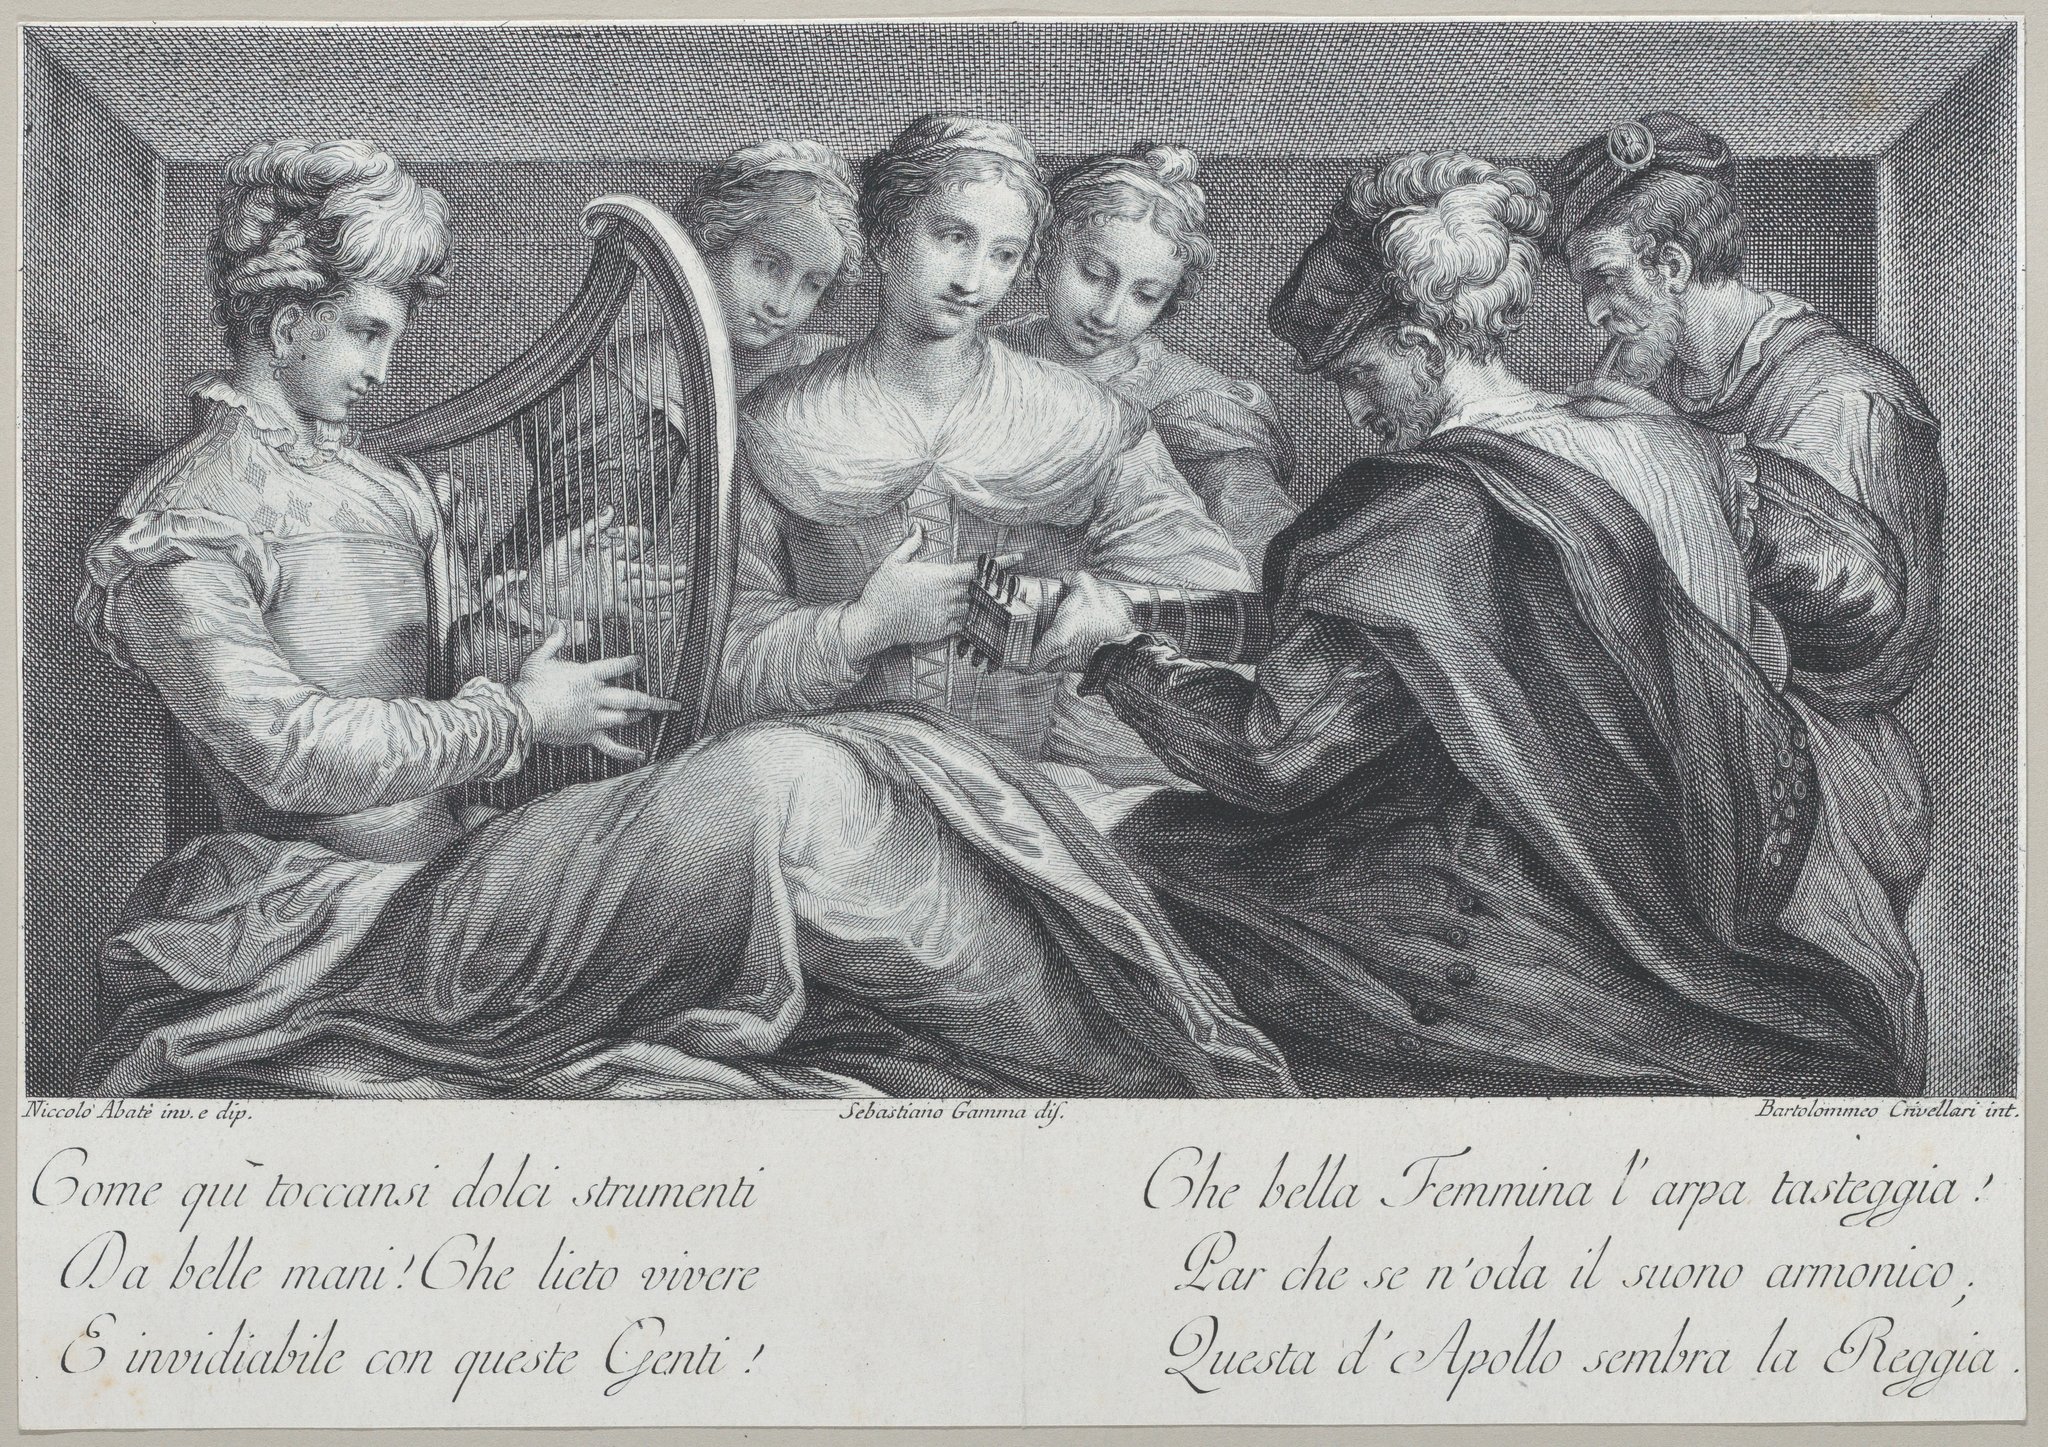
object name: print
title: A group of elegantly dressed people playing the harp and a guitar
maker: bartolomeo crivellari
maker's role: artist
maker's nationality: italian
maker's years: 1700-1800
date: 1740-1768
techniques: engraving